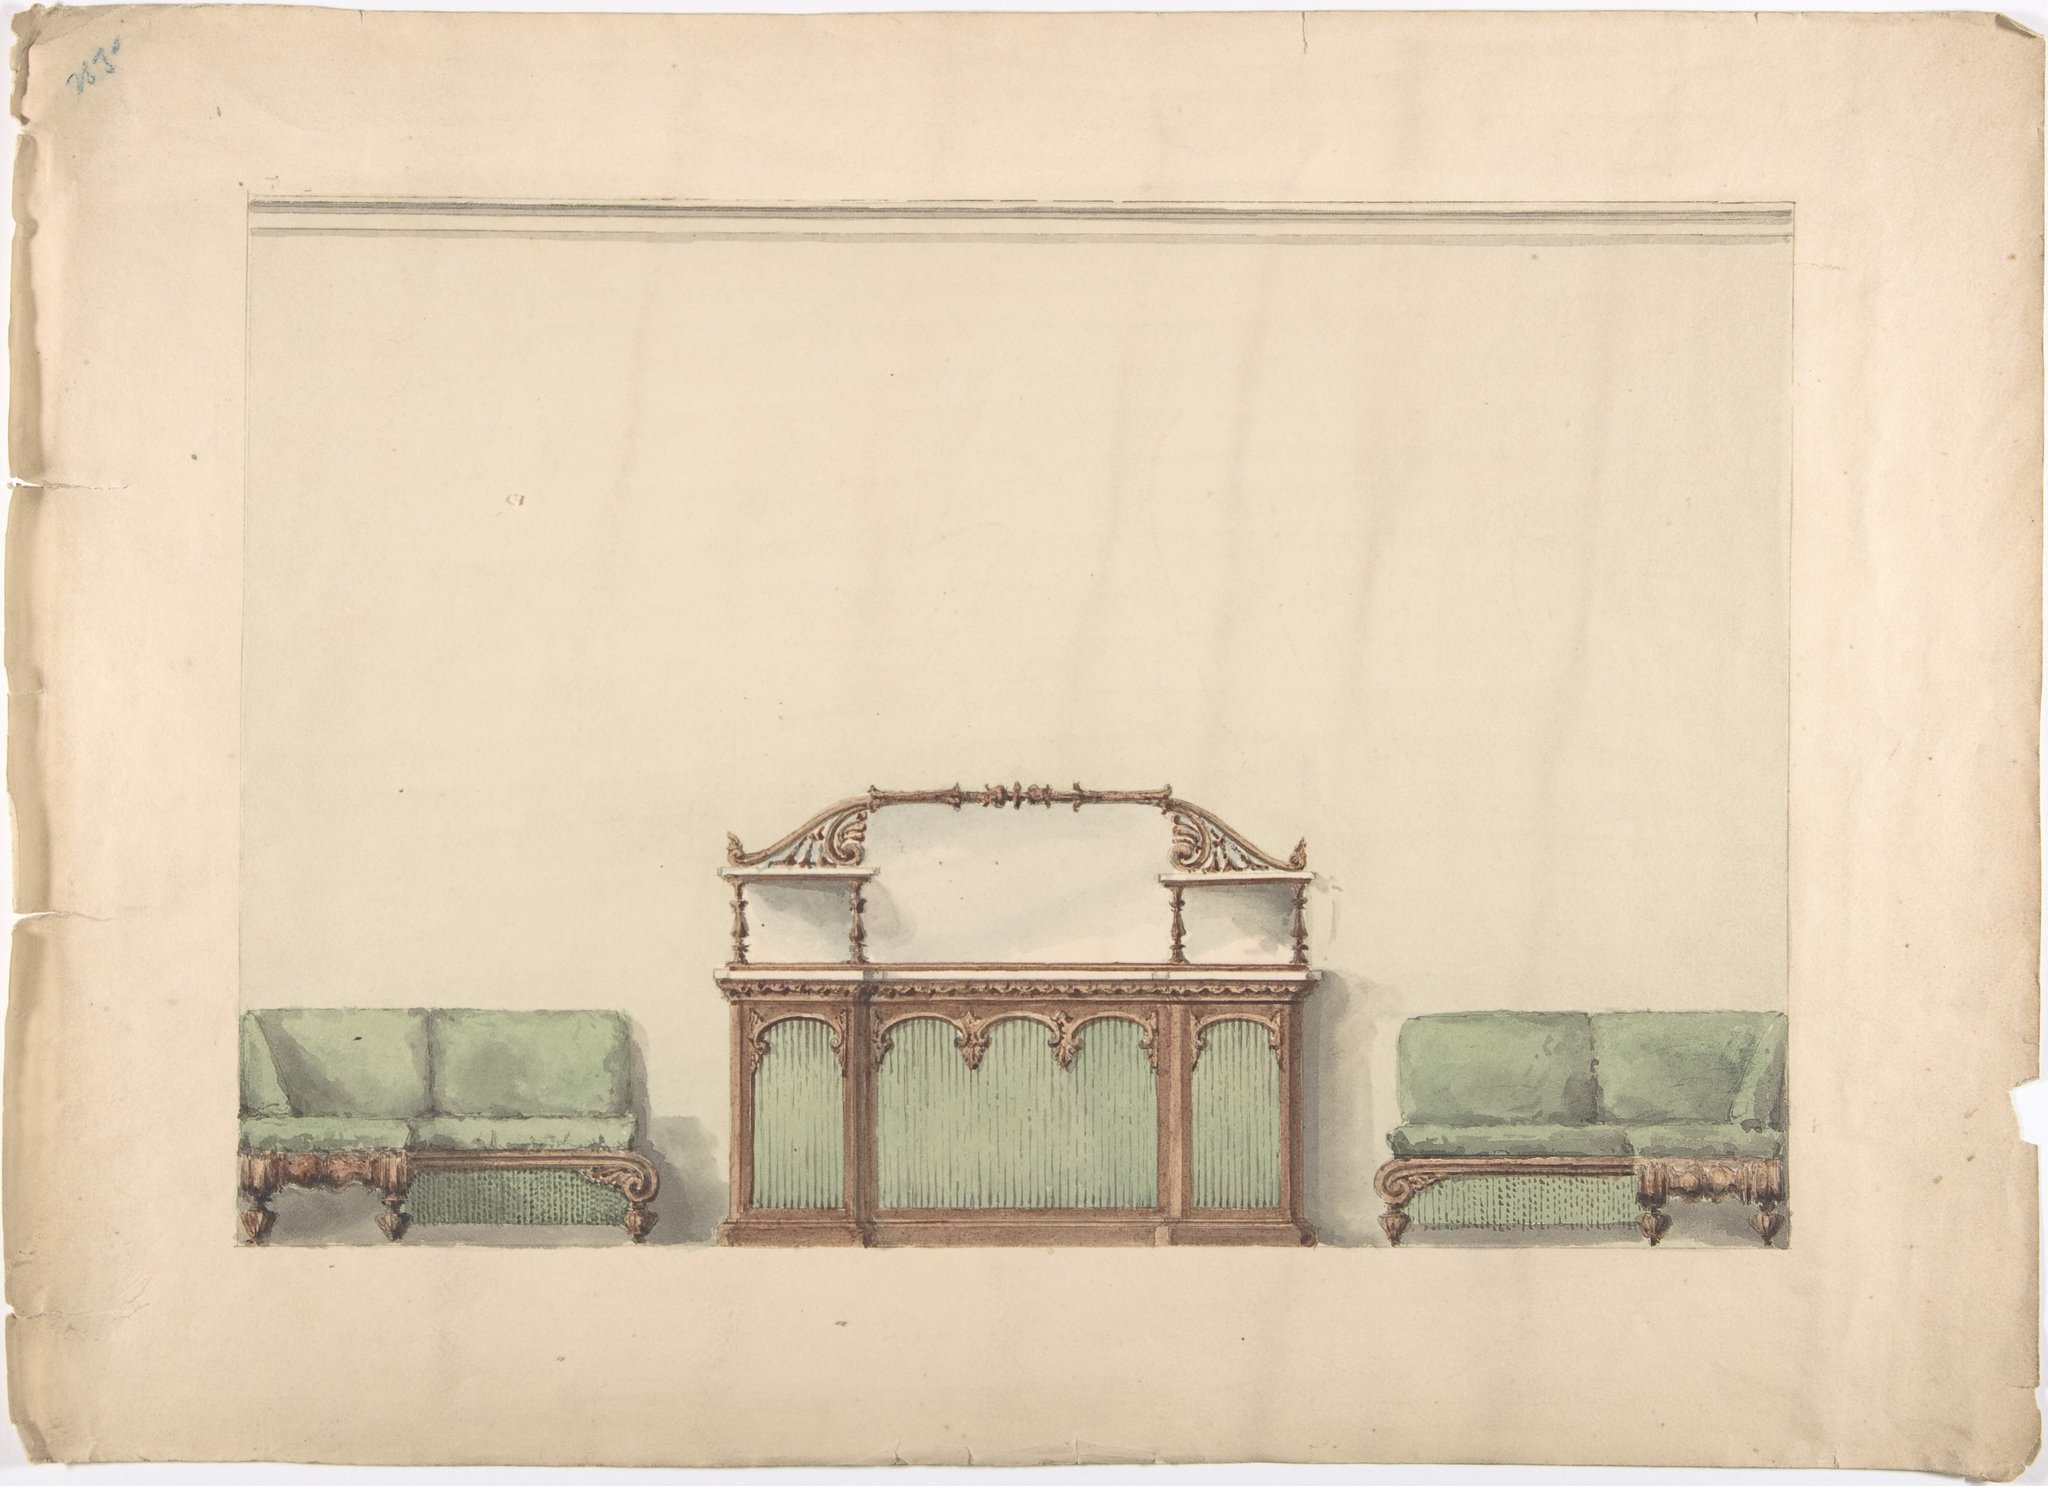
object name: drawing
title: Design for a Mirrored, Marble-topped Cabinet and Two Sofas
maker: anonymous, british, 19th century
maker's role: artist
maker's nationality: british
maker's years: 1800-1900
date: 1801-1833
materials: ink, watercolor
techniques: brush, pen, wash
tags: couches,cabinets,mirrors